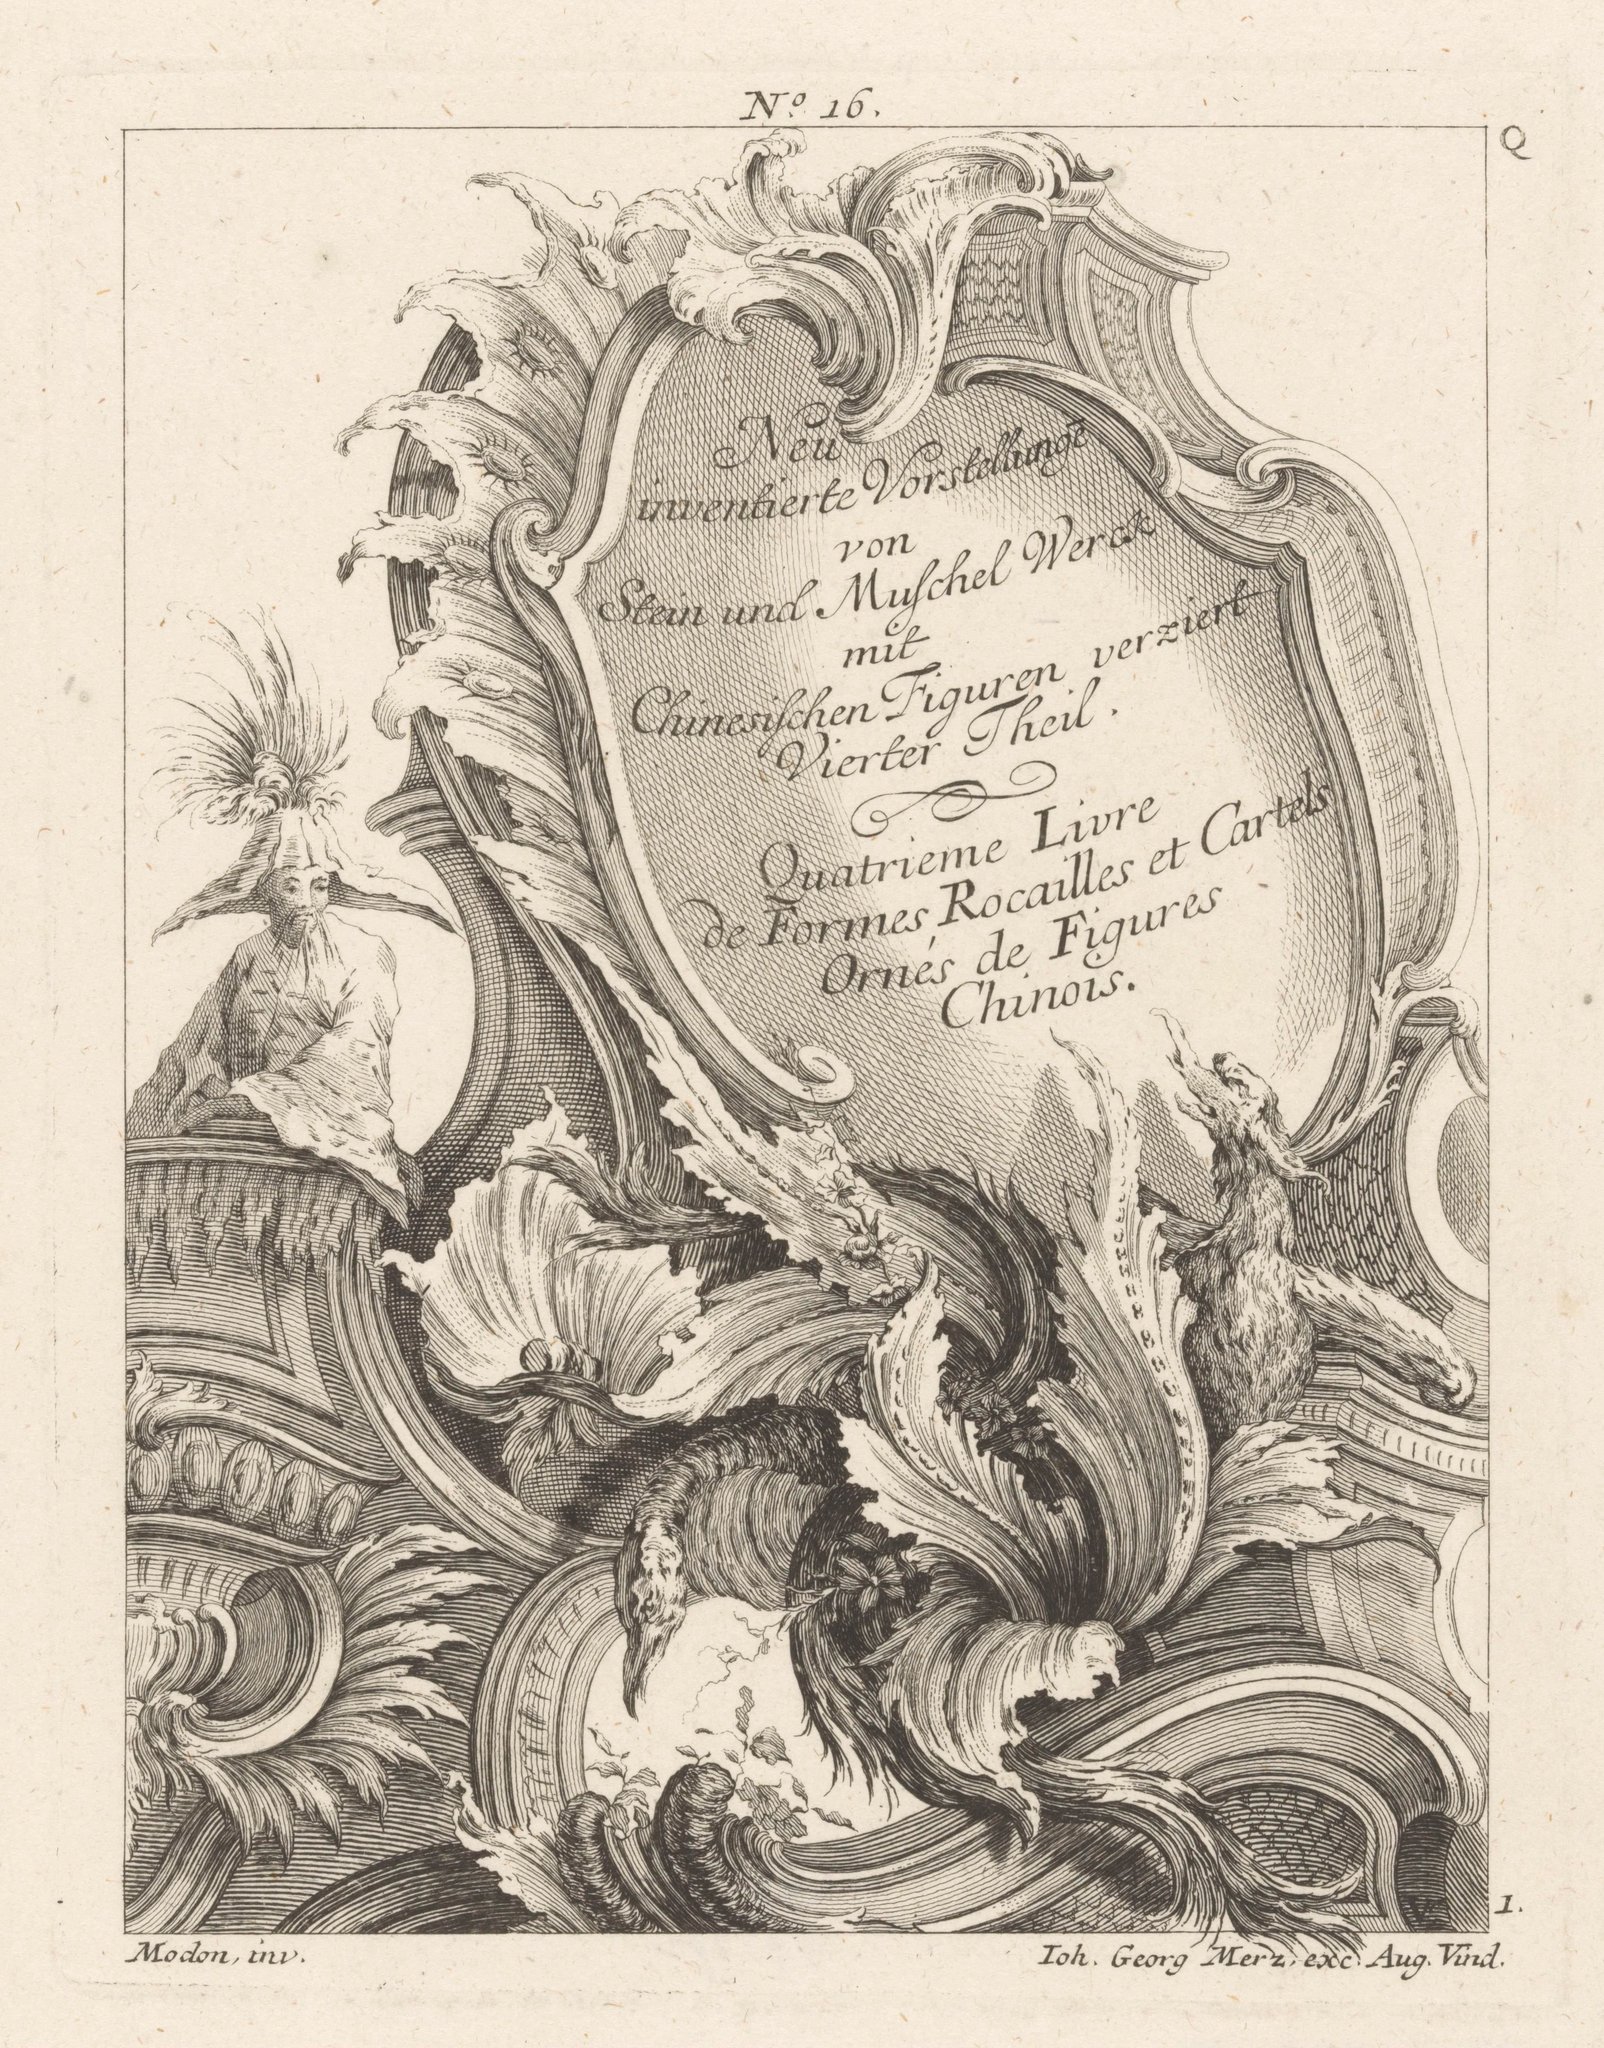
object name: print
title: Q Neu inventierte Vorstellunge von Stein und Muschel Werck mit Chinesischen Figuren, verziert Vierter Theil / Quatrieme Livre de Formes Rocailles et Cartels Ornés de Figures Chinois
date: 1736-1762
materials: paper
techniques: etching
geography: augsburg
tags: ornament ~ cartouche, dragon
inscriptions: collector's mark: Lugt 2228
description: Een rocaille cartouche met de serietitel. Links zit een oosterse man, voor de cartouche twee draken. Uitgeversnummer 16.